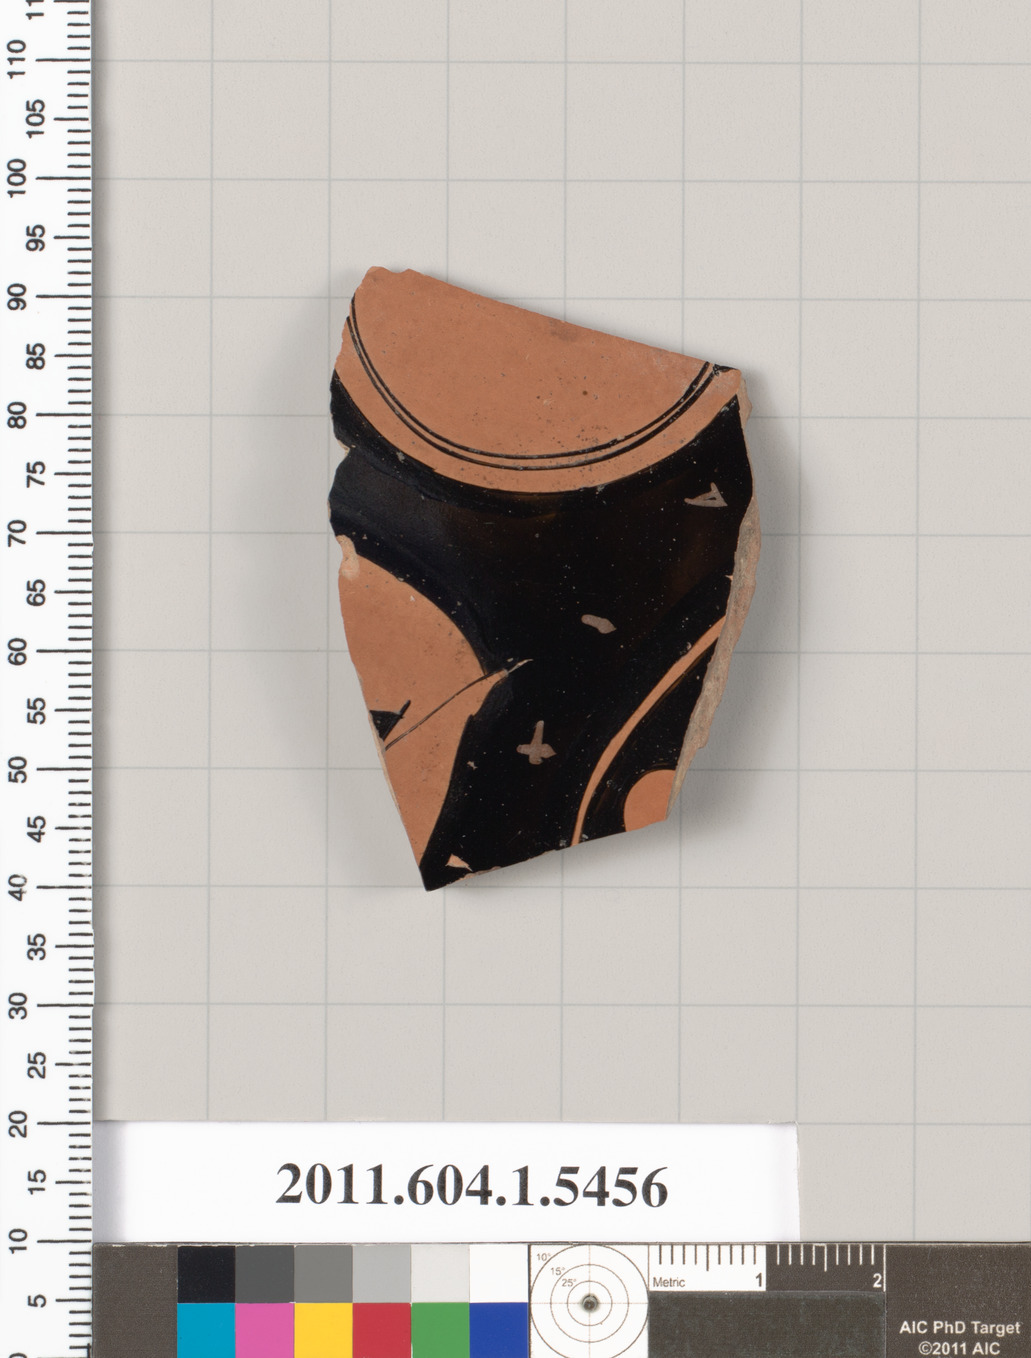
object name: kylix fragment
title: Terracotta fragment of a kylix (drinking cup)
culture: greek, attic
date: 520-510 BCE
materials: terracotta